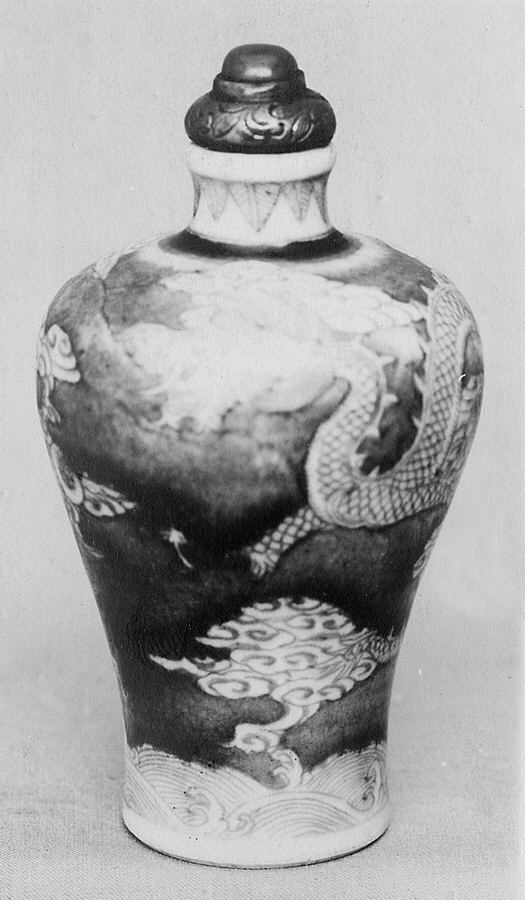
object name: snuff bottle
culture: chinese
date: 1723-1735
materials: porcelain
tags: dragons